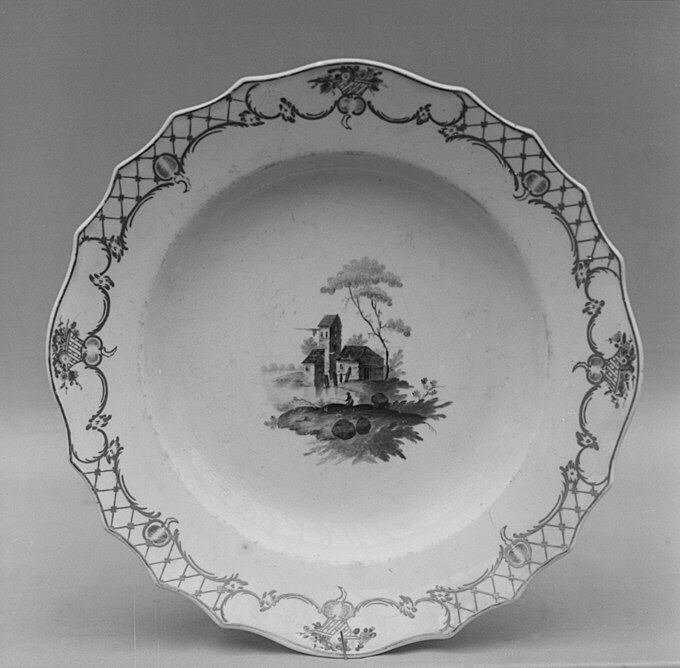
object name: plate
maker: the hague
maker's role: factory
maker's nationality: dutch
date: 1780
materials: hard paste porcelain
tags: houses,trees